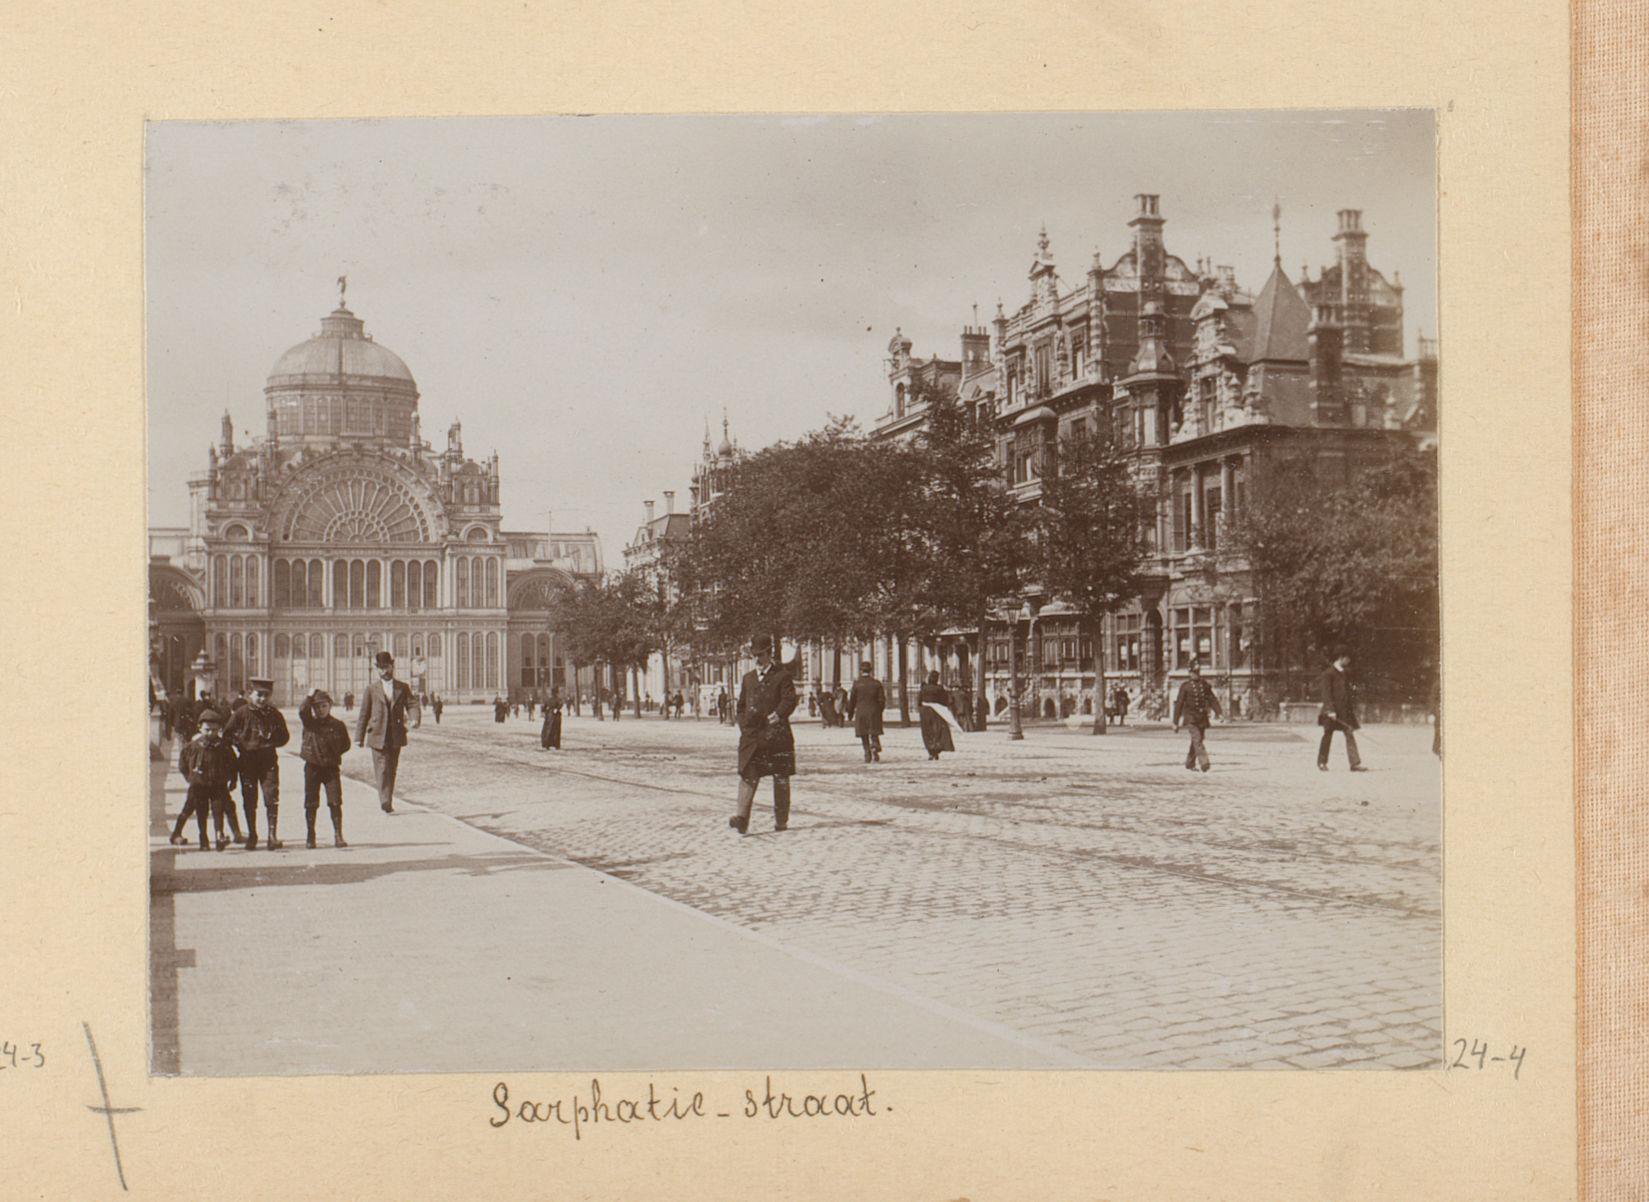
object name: photograph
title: Sarphatistraat richting het Frederiksplein en het Paleis voor Volksvlijt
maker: hendrik herman van den berg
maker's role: amateurfotograaf, jurist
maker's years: 1875-1944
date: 1890-1894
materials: paper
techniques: collodion silver print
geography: amsterdam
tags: urban housing, palace, street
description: Foto 4 op albumblad 24 uit album "Amsterdam 1890-1894".